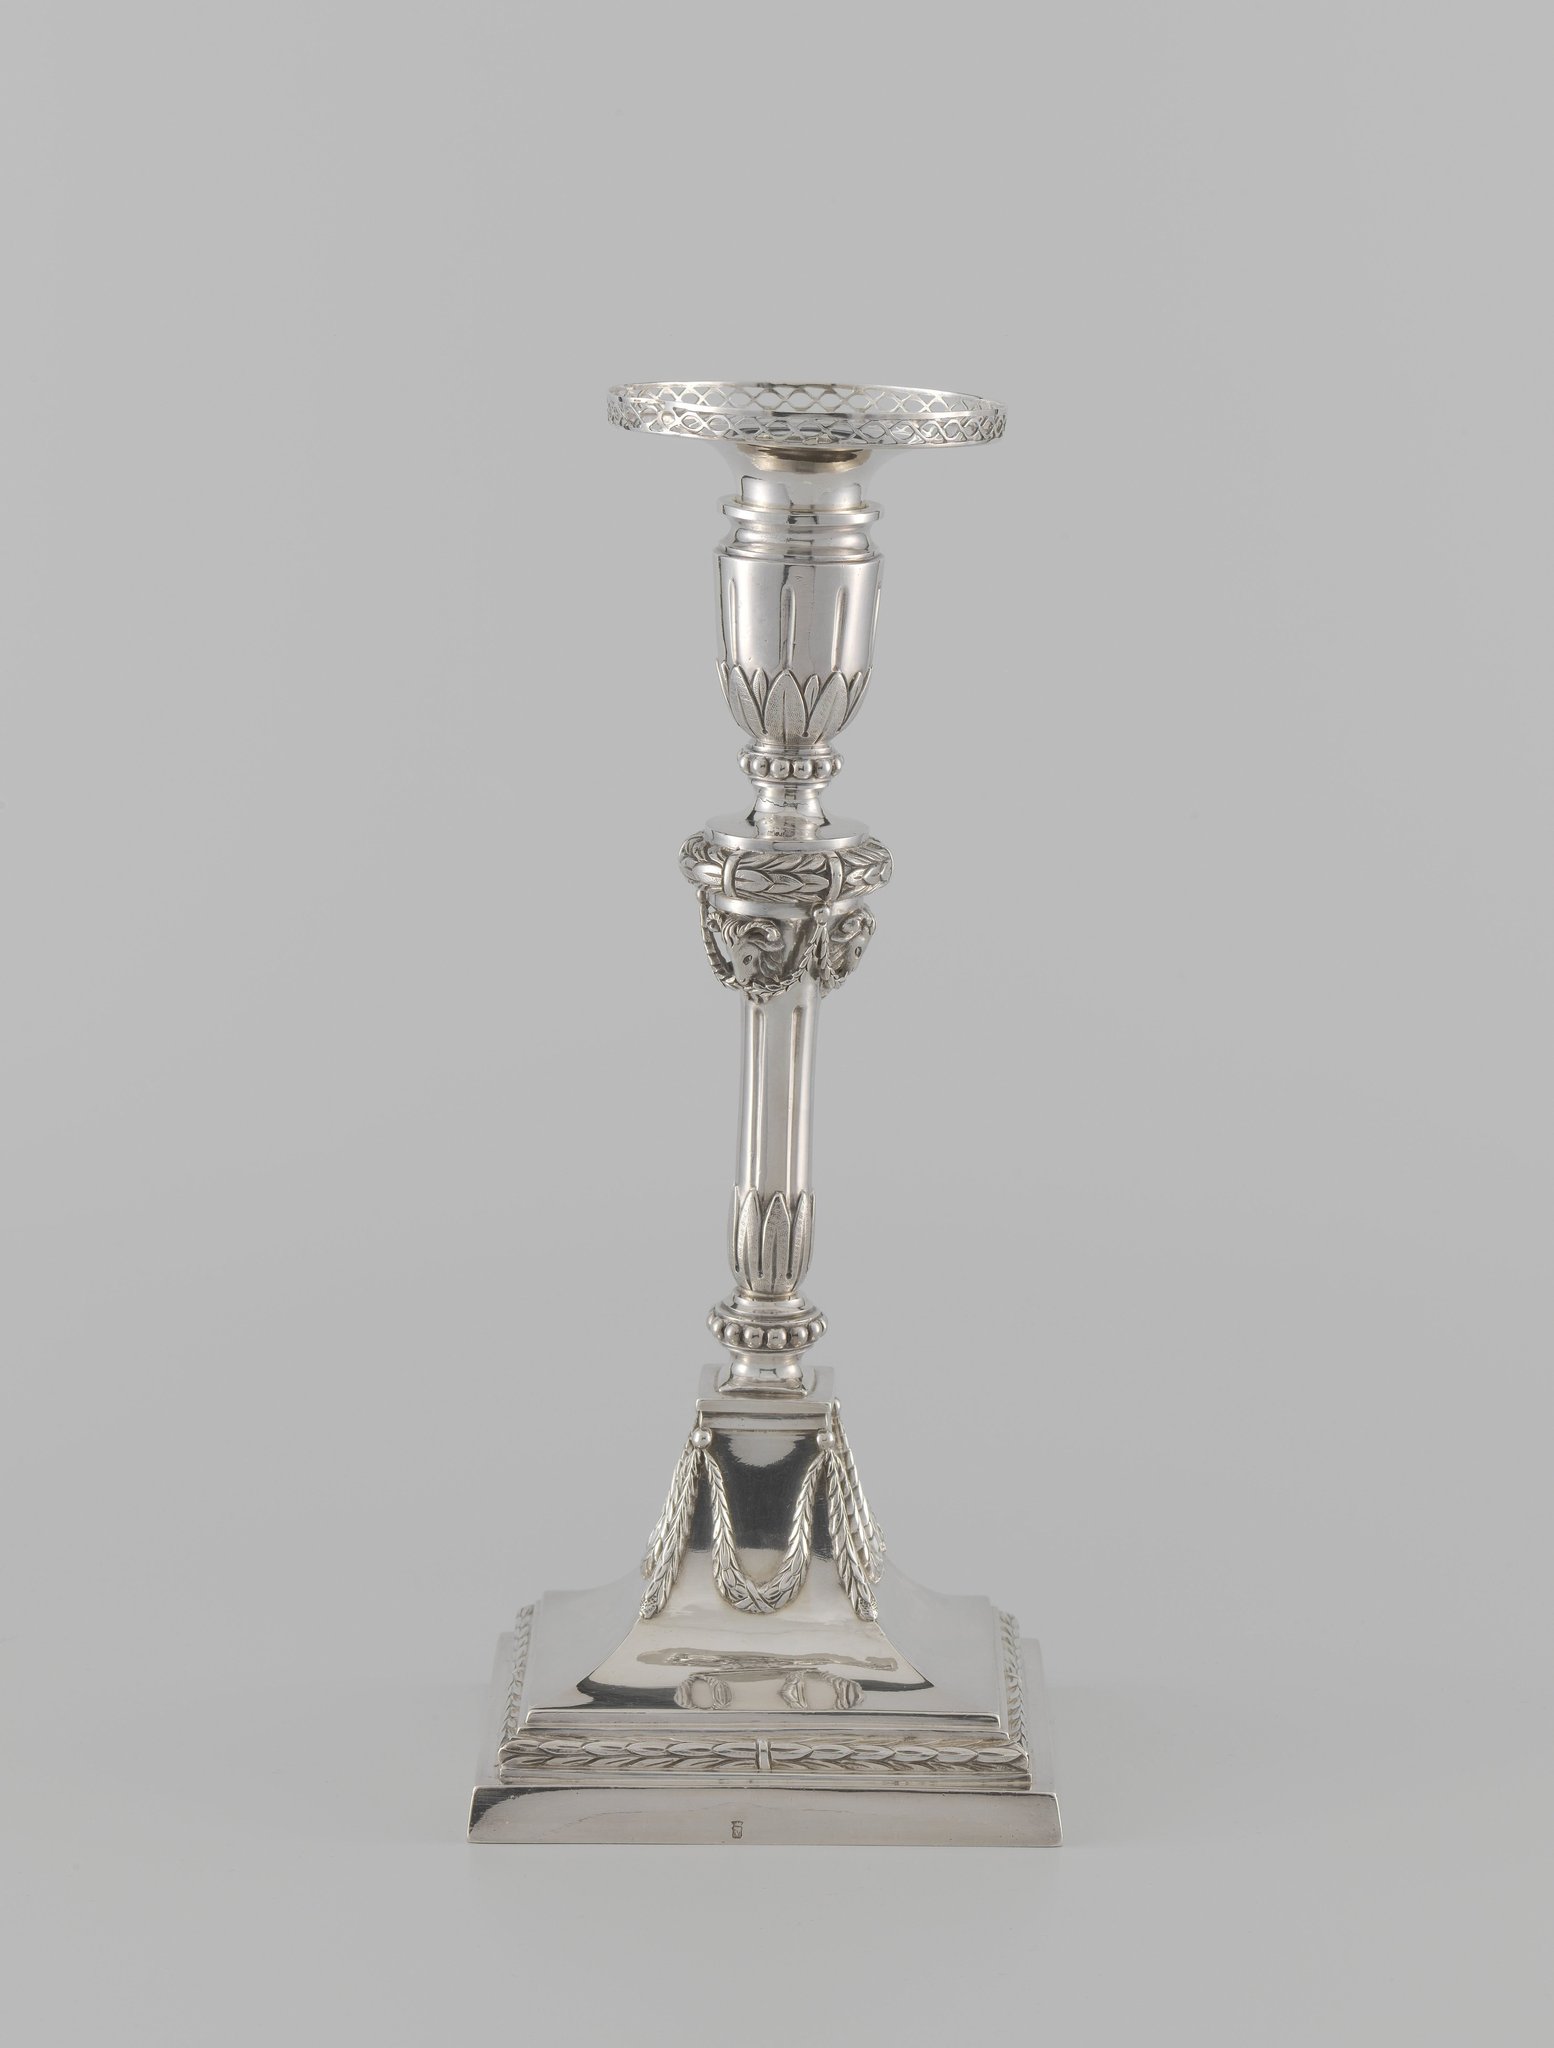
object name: candlestick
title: Kandelaar van zilver met vierkante voet en ronde stam, kaarsenhouder en losse vetvanger.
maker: johannes henricus pluygers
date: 1783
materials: silver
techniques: casting, metalworking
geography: the hague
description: Kandelaar bestaande uit een vierkante voet en een ronde stam, kaarsenhouder en losse vetvanger. Gemerkt en gedateerd.